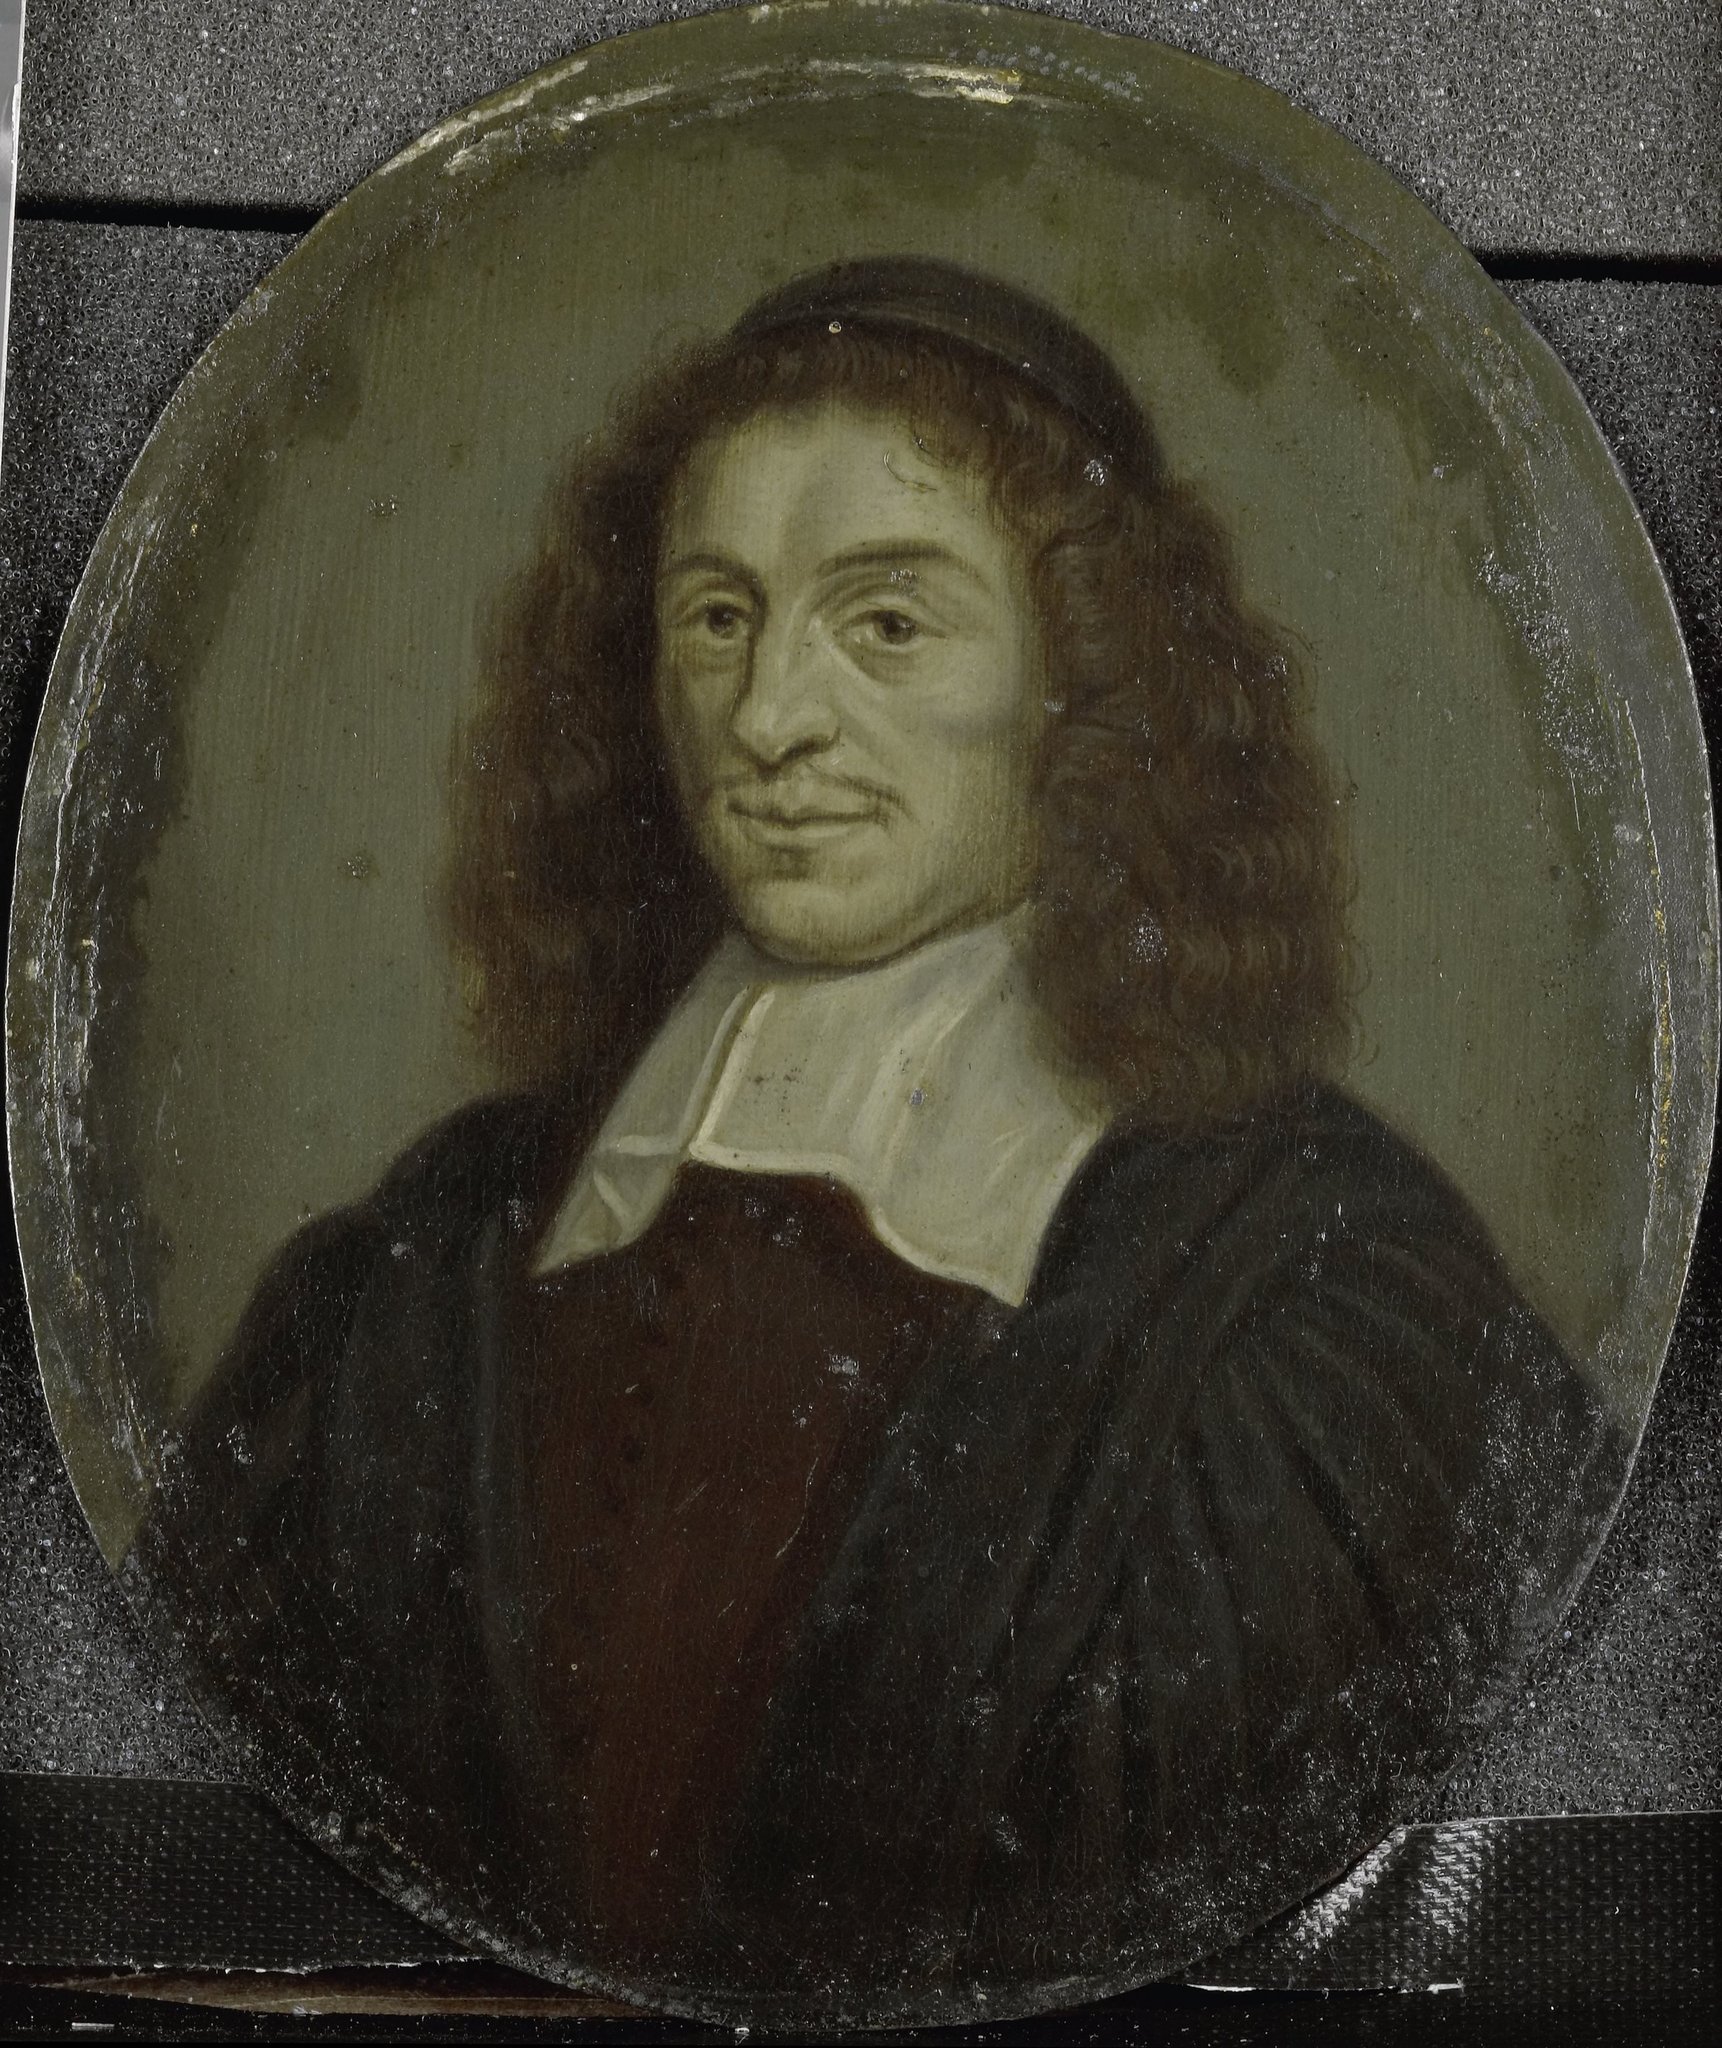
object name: painting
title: Portrait of Alexander Morus, Professor at Amsterdam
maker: arnoud van halen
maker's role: draughtsman, painter, print maker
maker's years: 1673-1732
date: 1700-1732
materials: oil, metal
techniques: grisaille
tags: alexander morus, portrait of a writer, writer, poet, author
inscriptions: inscription: ‘Alexander Morus. 1616’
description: Portret van Alexander Morus (1616-70). Hoogleraar te Amsterdam. Buste in ovaal, naar links. Onderdeel van een verzameling portretten van Nederlandse dichters.